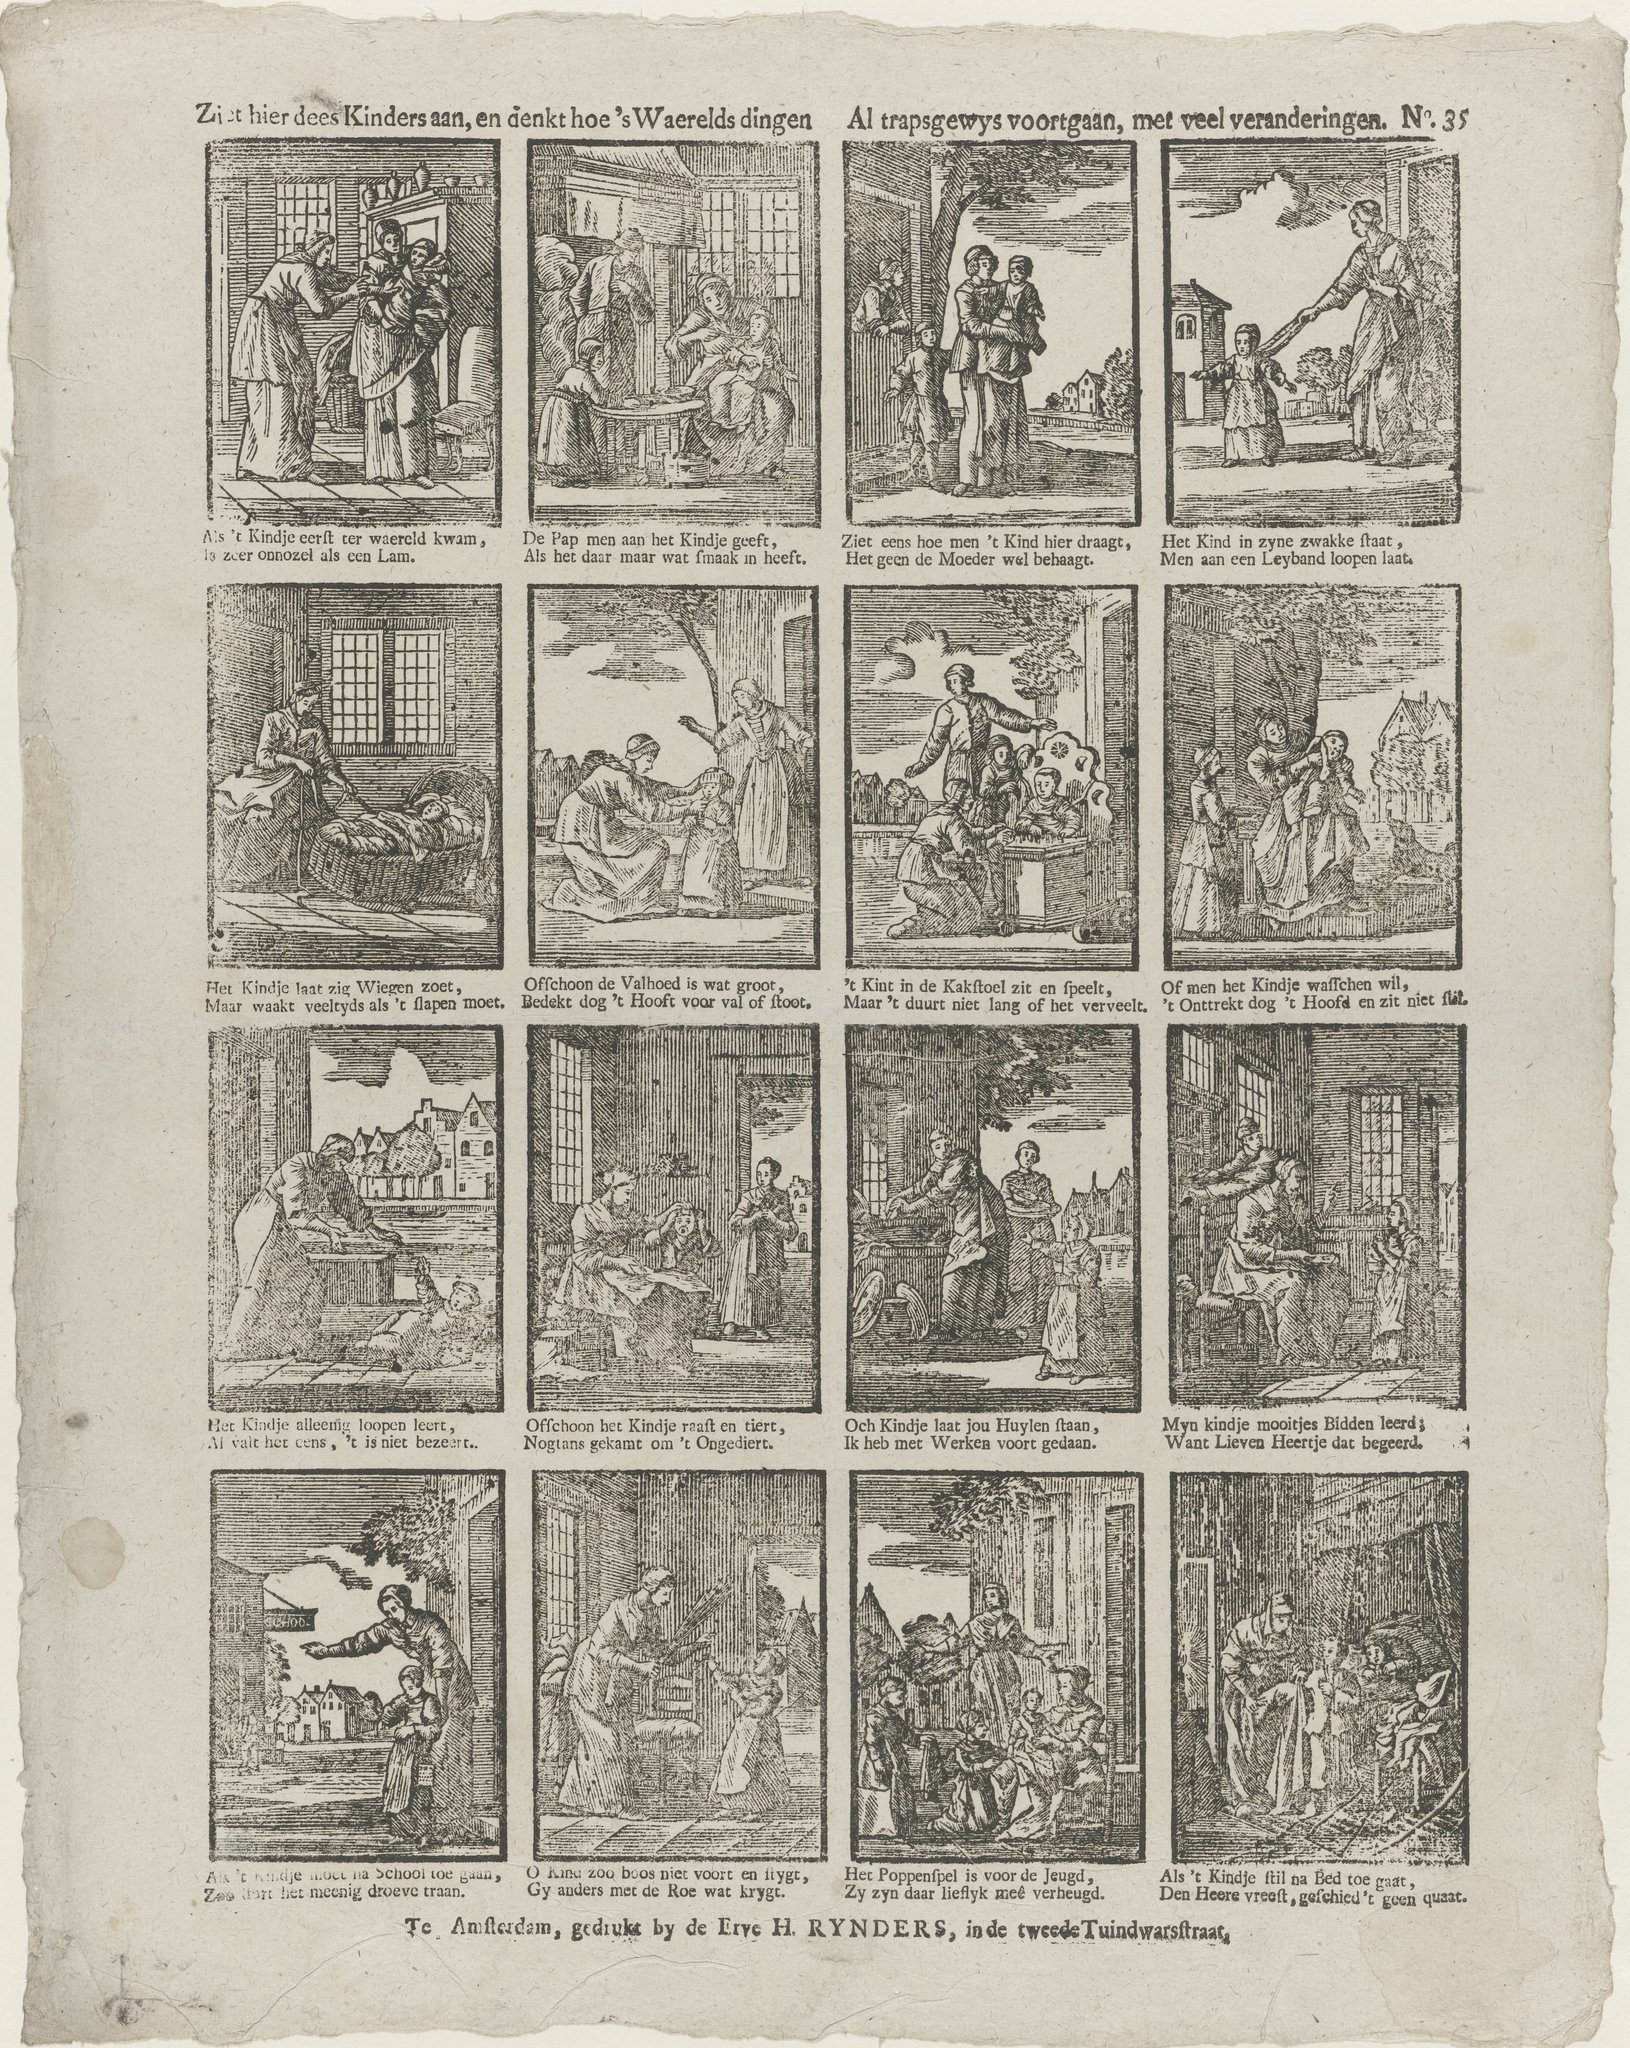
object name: popular print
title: Ziet hier dees kinders aan, en denkt hoe 's waerelds dingen / Al trapsgewys voortgaan, met veel veranderingen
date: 1831-1854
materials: paper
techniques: letterpress printing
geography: amsterdam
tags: education, science and learning, child, learning to walk, the first steps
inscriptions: collector's mark: Lugt 2760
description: Blad met 16 voorstellingen over het kinderleven. Onder elke afbeelding een tweeregelig vers. Genummerd rechtsboven: No. 35.